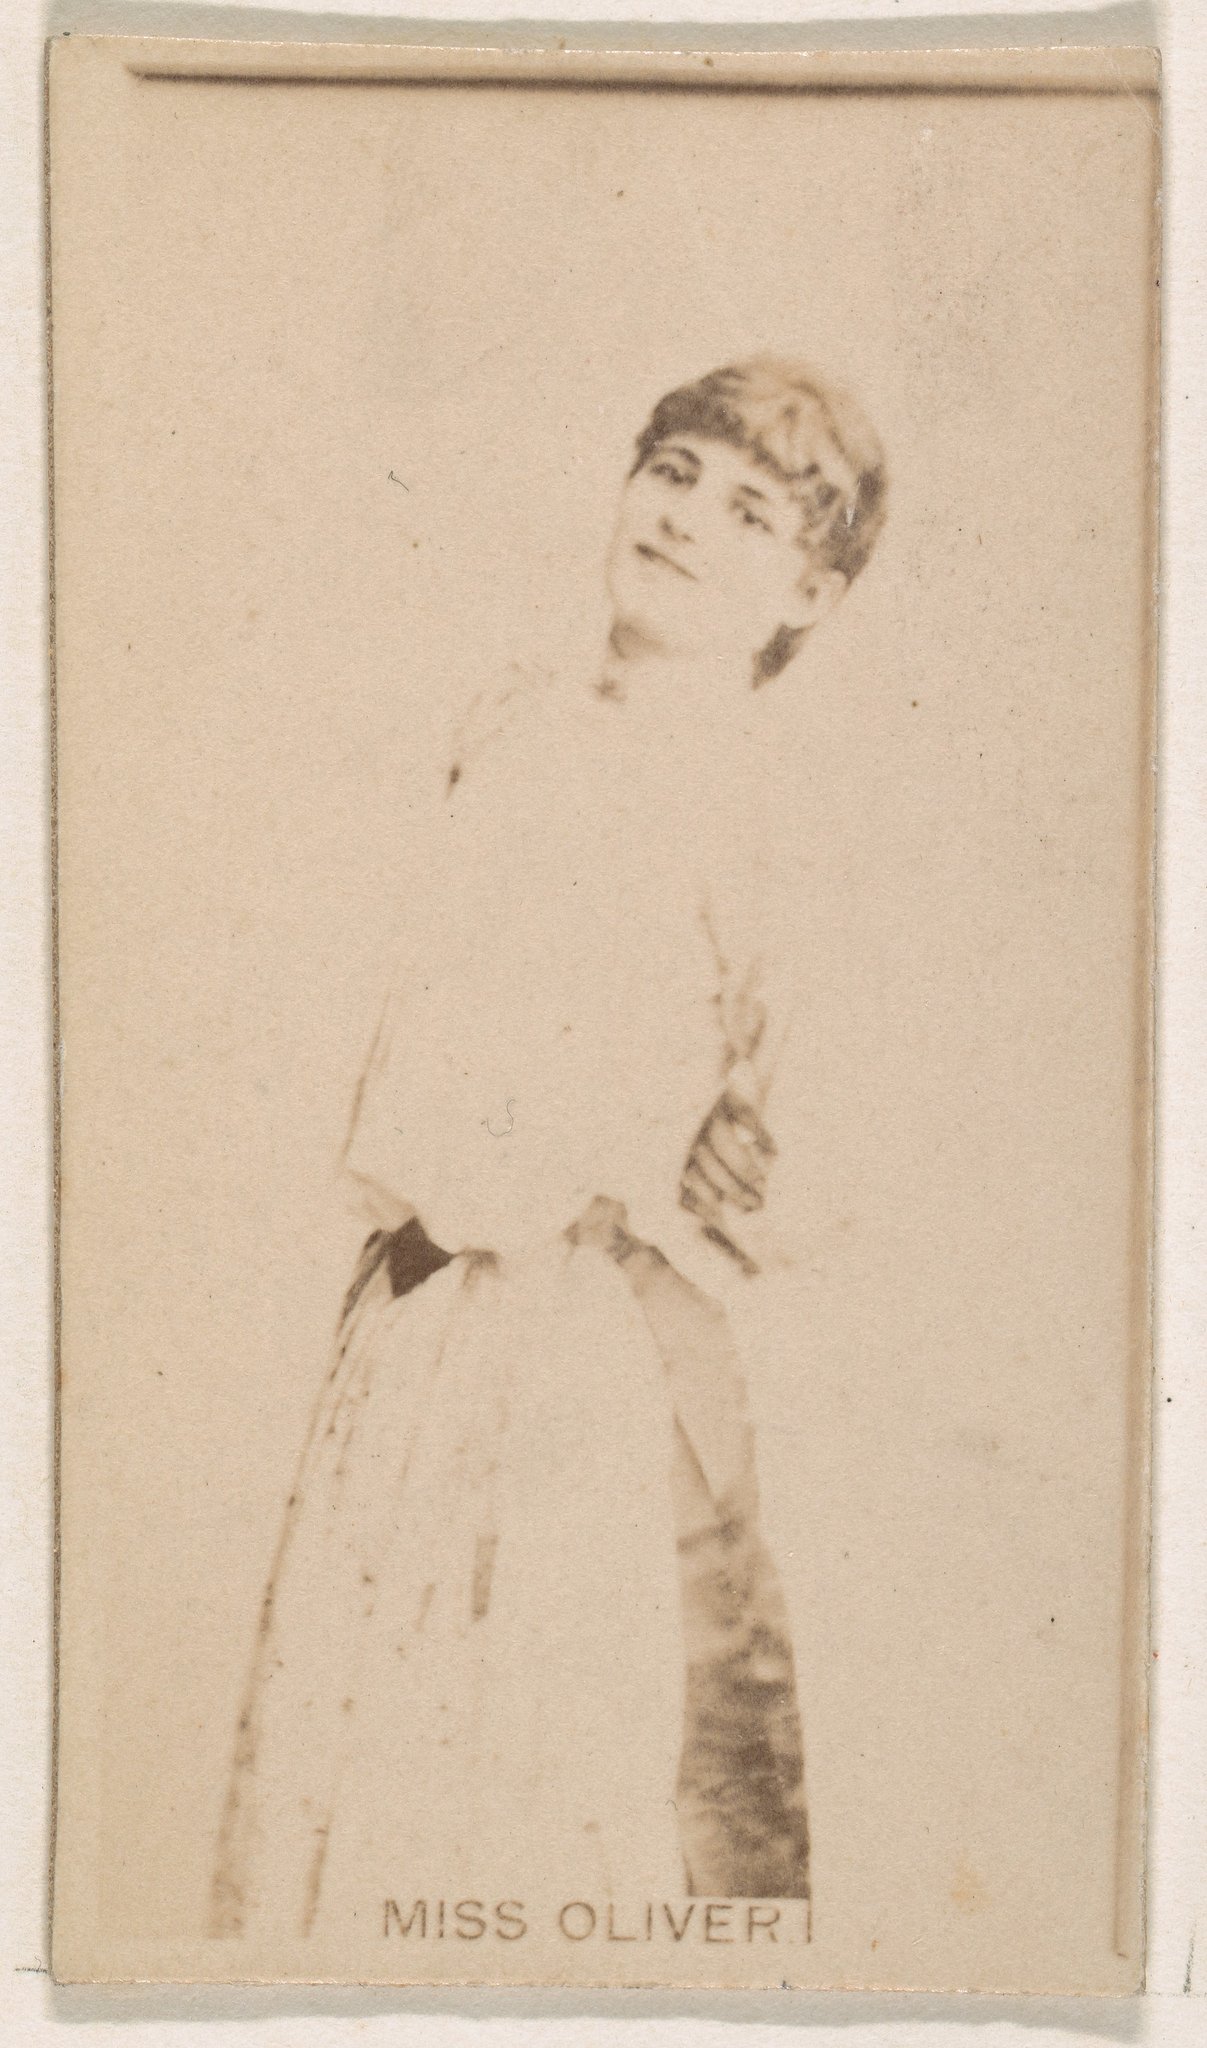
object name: photograph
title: Miss Oliver, from the Actresses series (N245) issued by Kinney Brothers to promote Sweet Caporal Cigarettes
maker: kinney brothers tobacco company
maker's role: publisher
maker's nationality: american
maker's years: 1869-2011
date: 1890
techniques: albumen silver print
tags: portraits,women,actresses